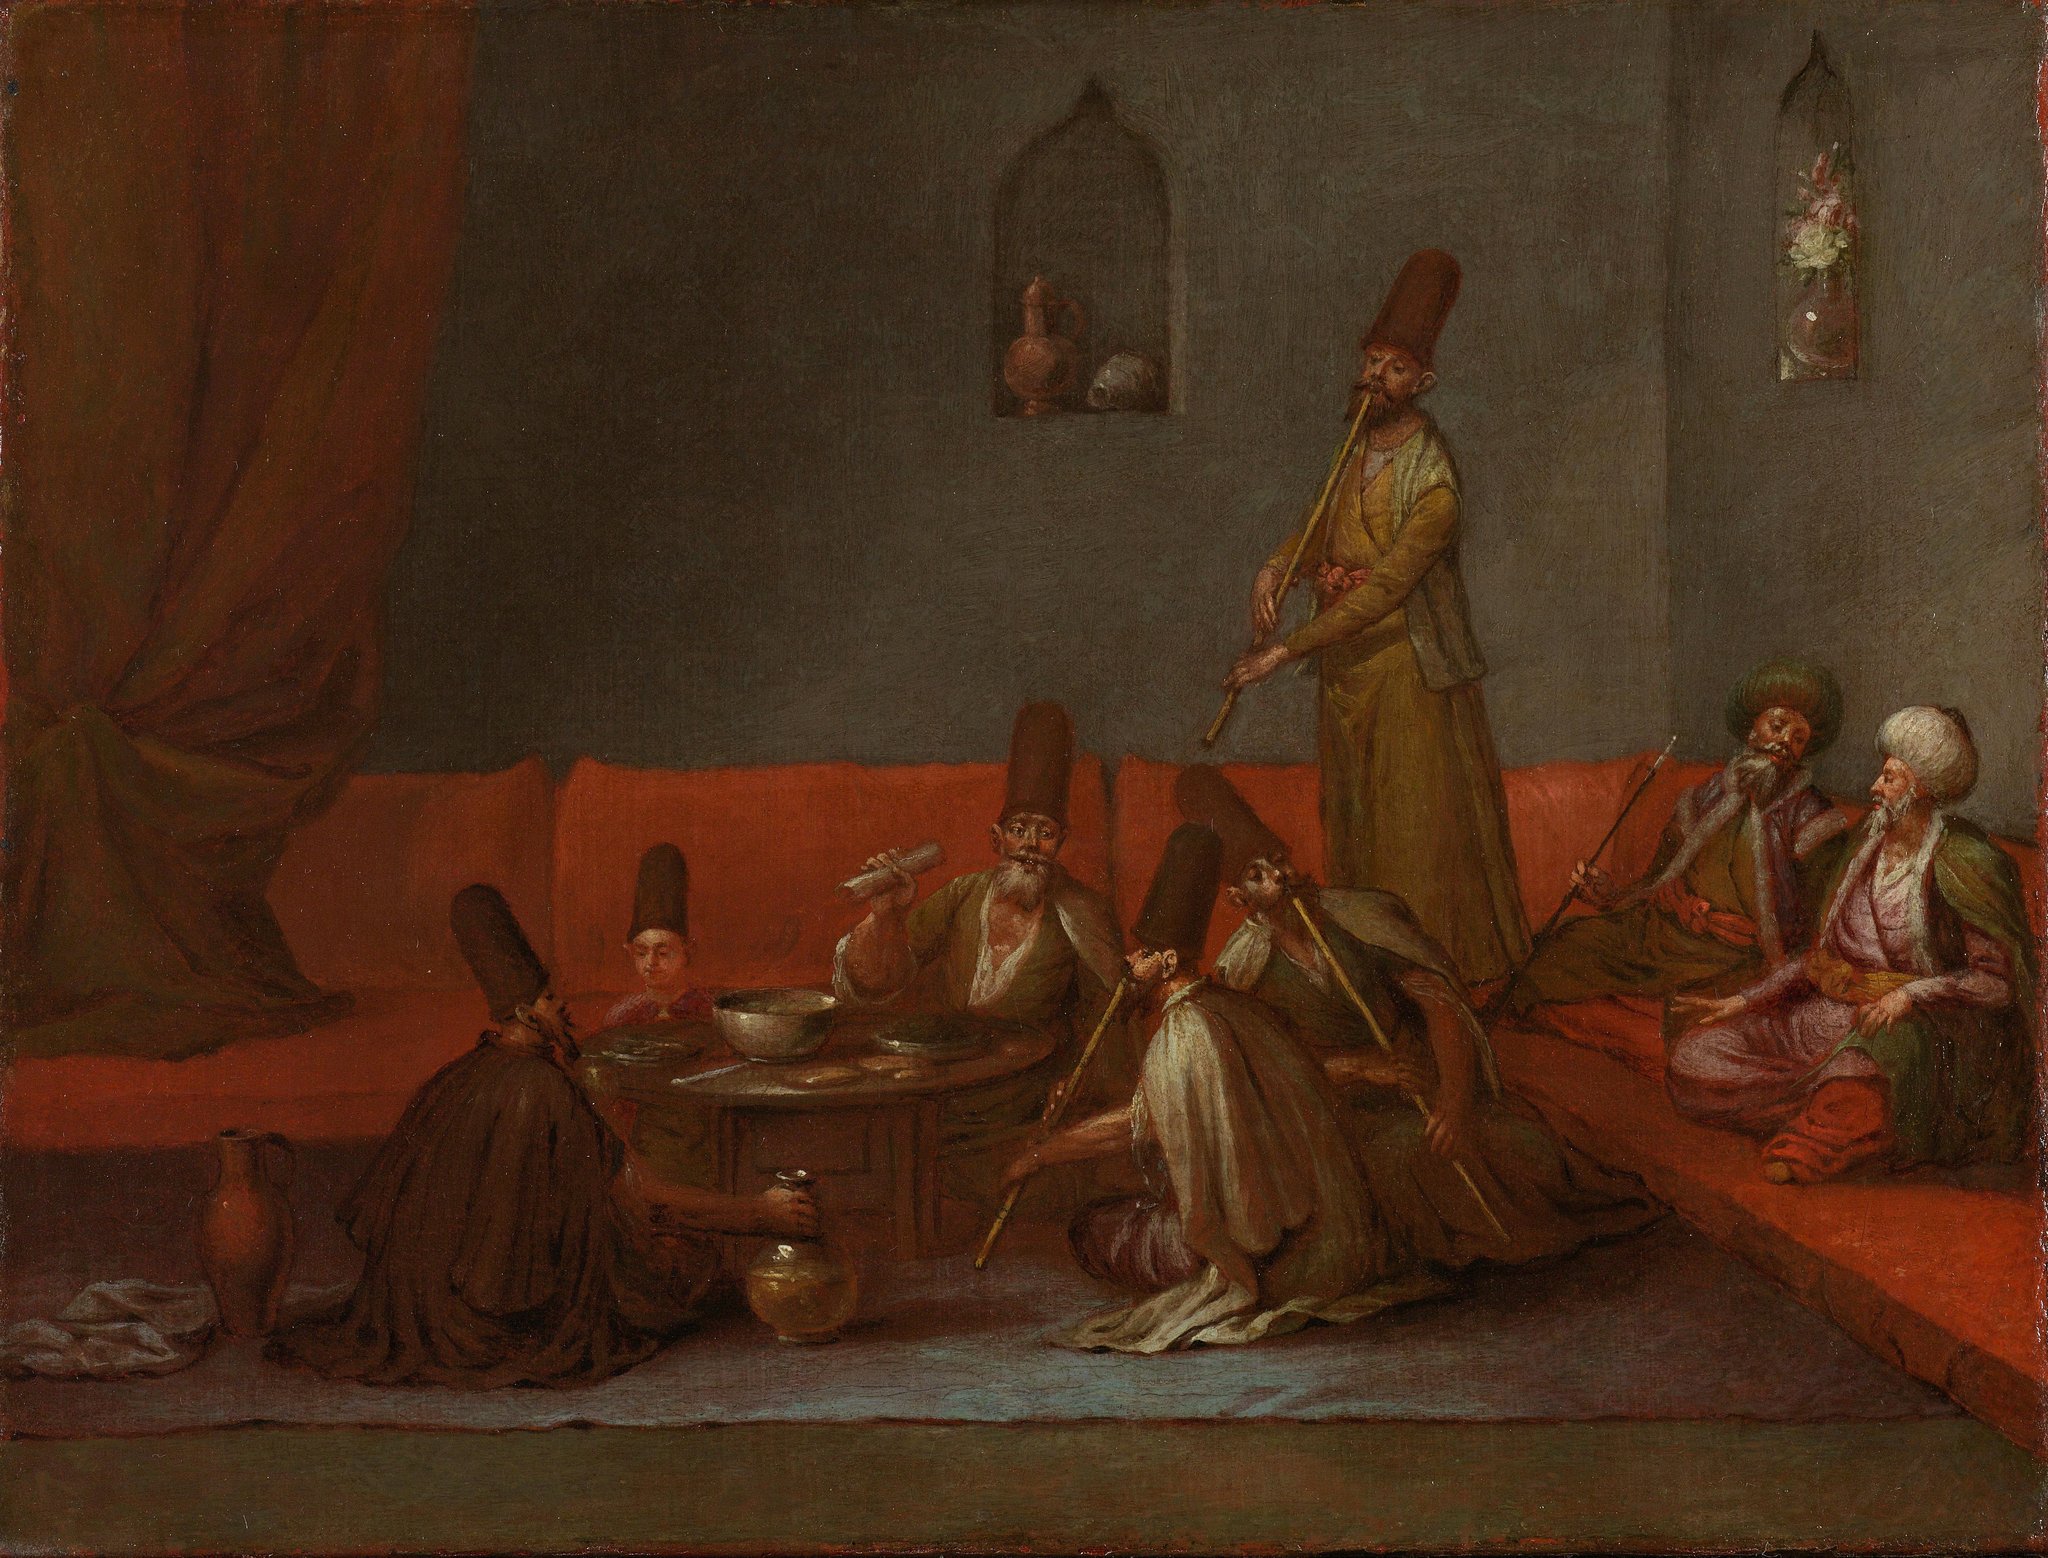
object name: painting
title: Dervishes Sharing a Meal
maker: jean baptiste vanmour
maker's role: painter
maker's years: 1671-1737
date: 1720-1737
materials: canvas, oil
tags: religious communities ~ islam, mohammedanism, (family) meal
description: Dervishes lived together in a tekke, which, besides a prayer hall, included living quarters, a library, a dining hall and a kitchen. The dervishes wear a sikke, their typical conical hat, and long woollen robes.